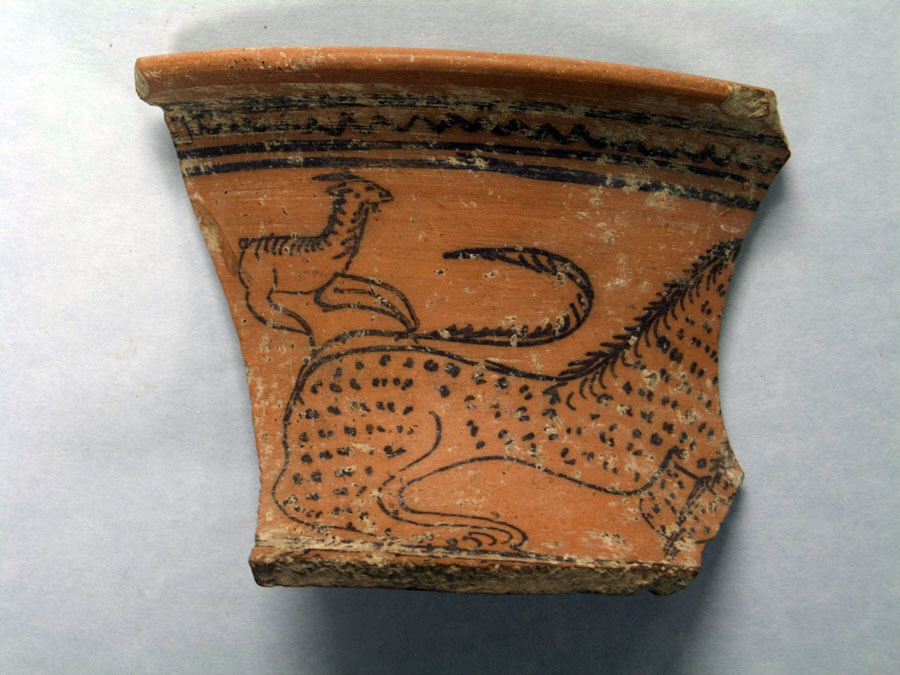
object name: shard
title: Shard: Neck of Vessel with Carnivore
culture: pakistani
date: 301-500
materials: terracotta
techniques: painting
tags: animals,gandhara